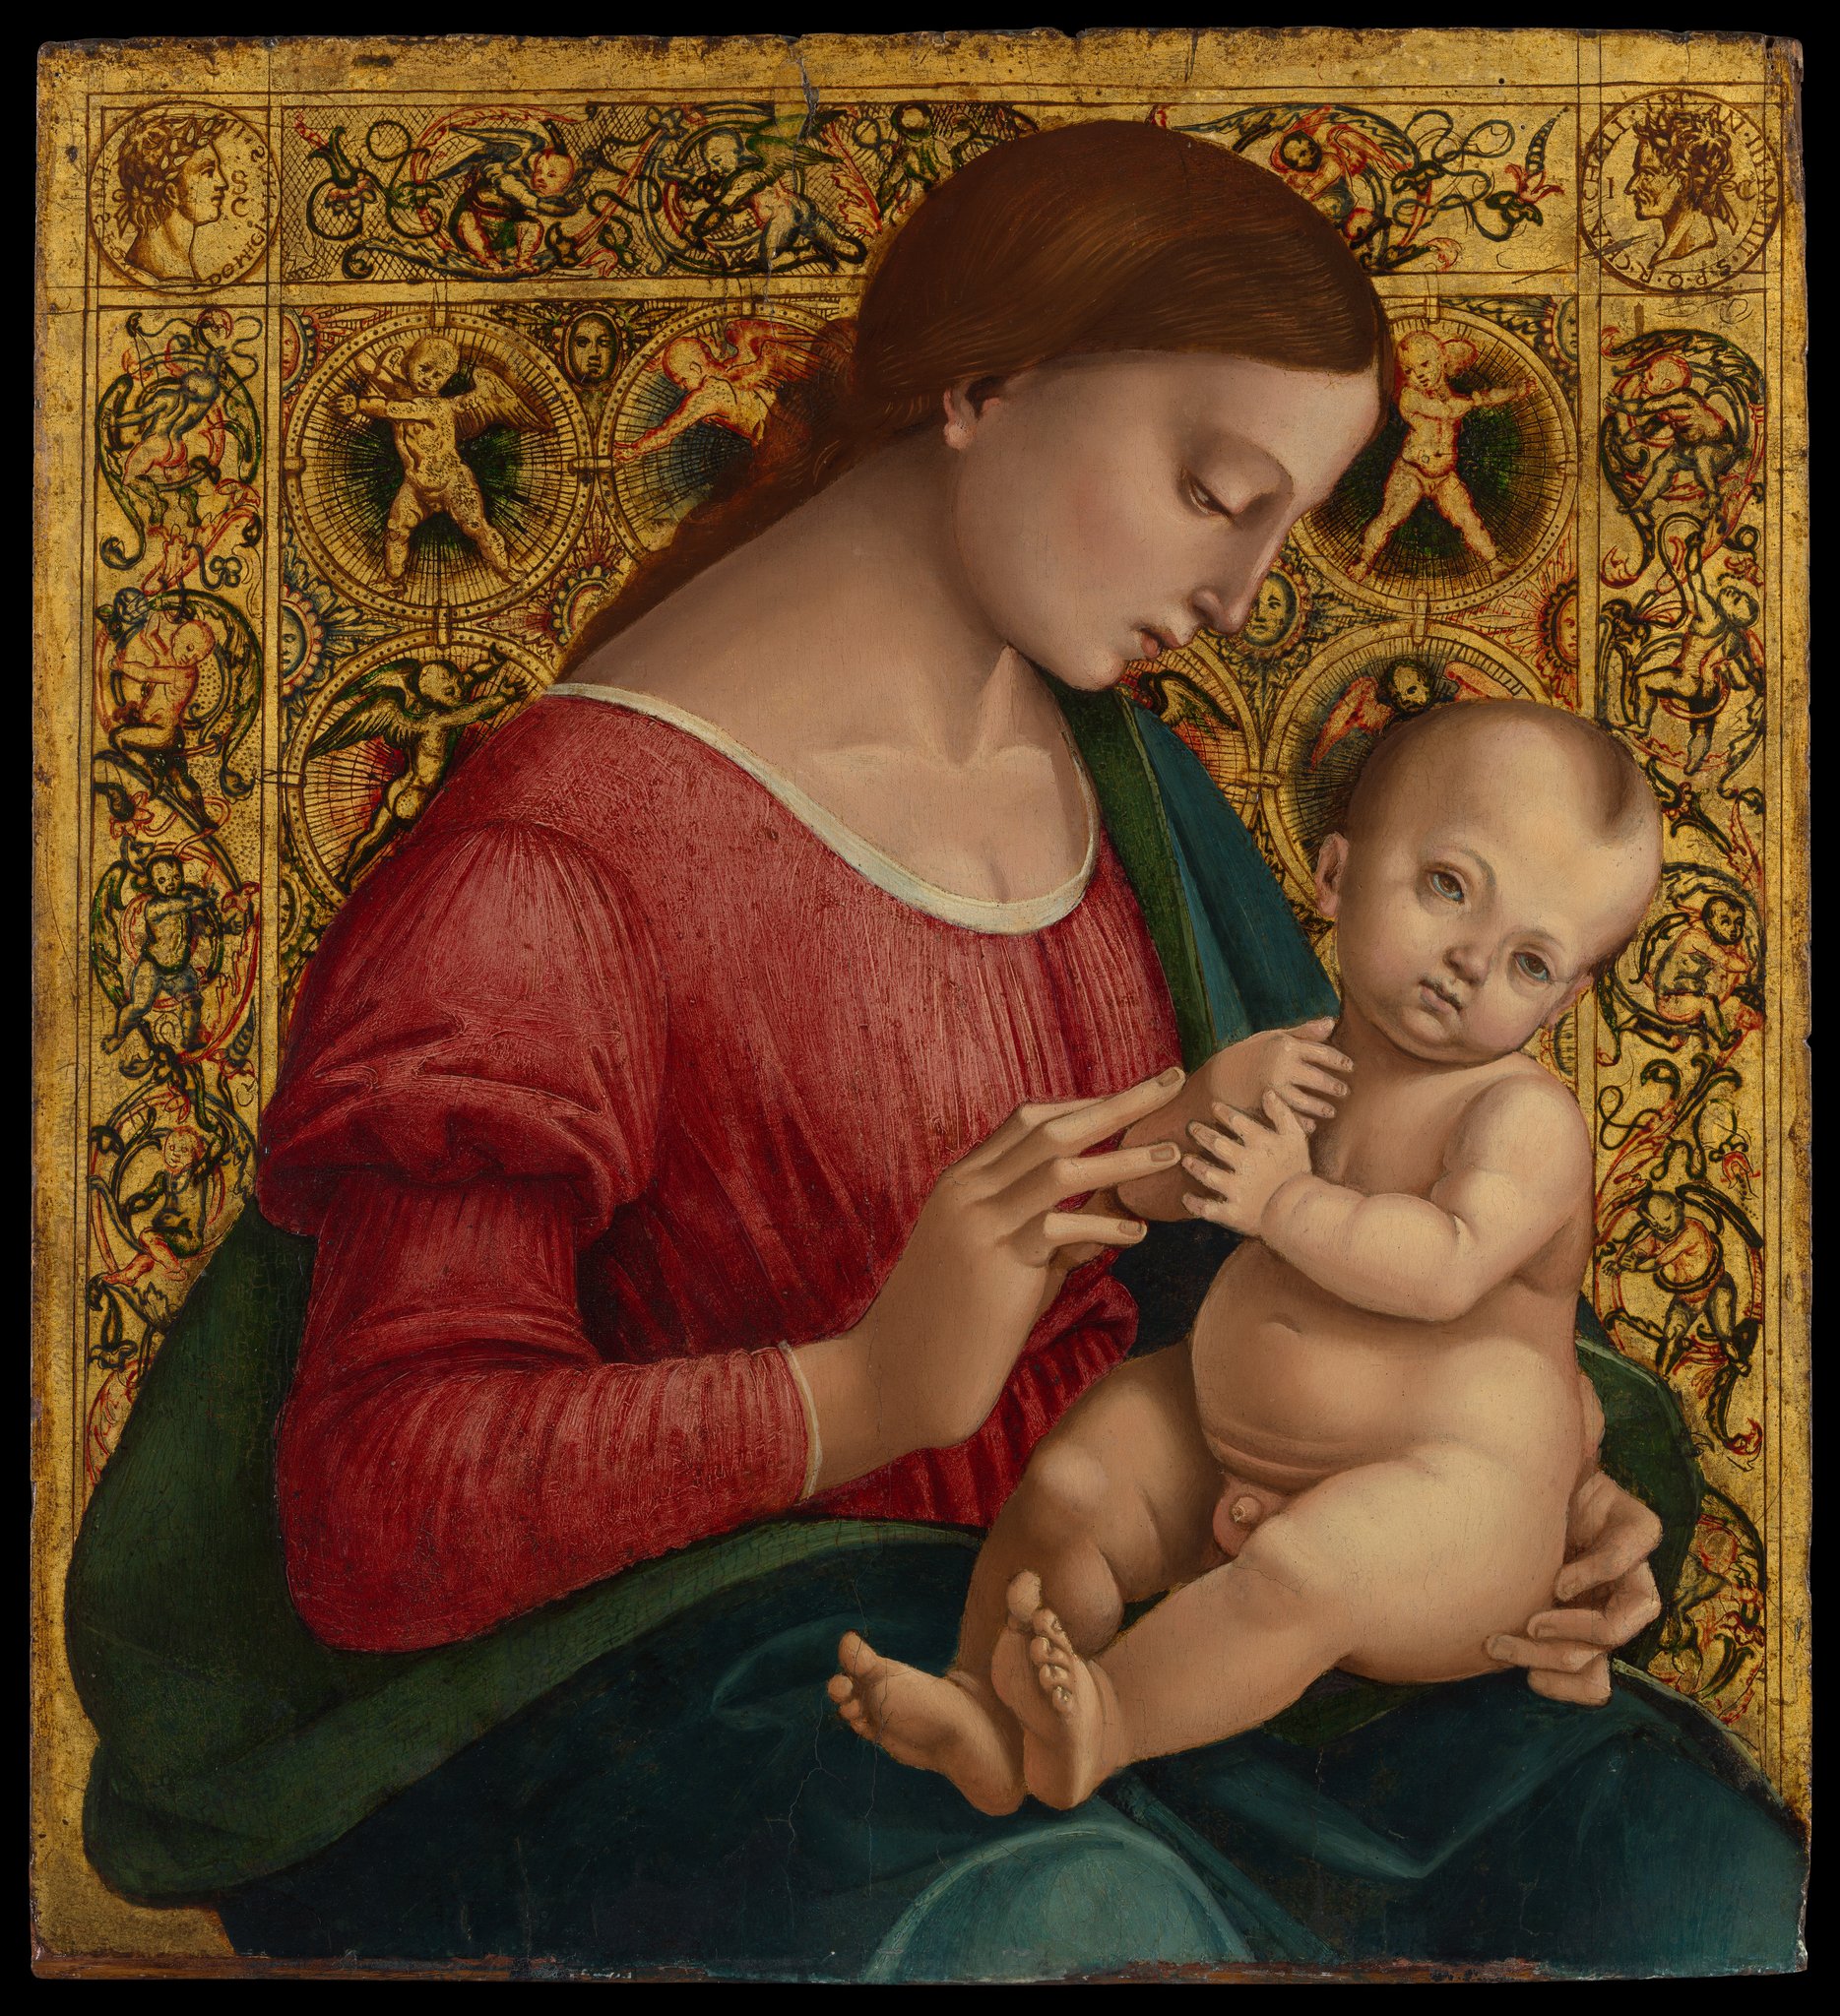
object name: painting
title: Madonna and Child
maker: luca signorelli (luca d'egidio di luca di ventura)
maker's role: artist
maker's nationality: italian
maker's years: 1470-1523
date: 1505-1507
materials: gold, oil, wood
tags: madonna and child